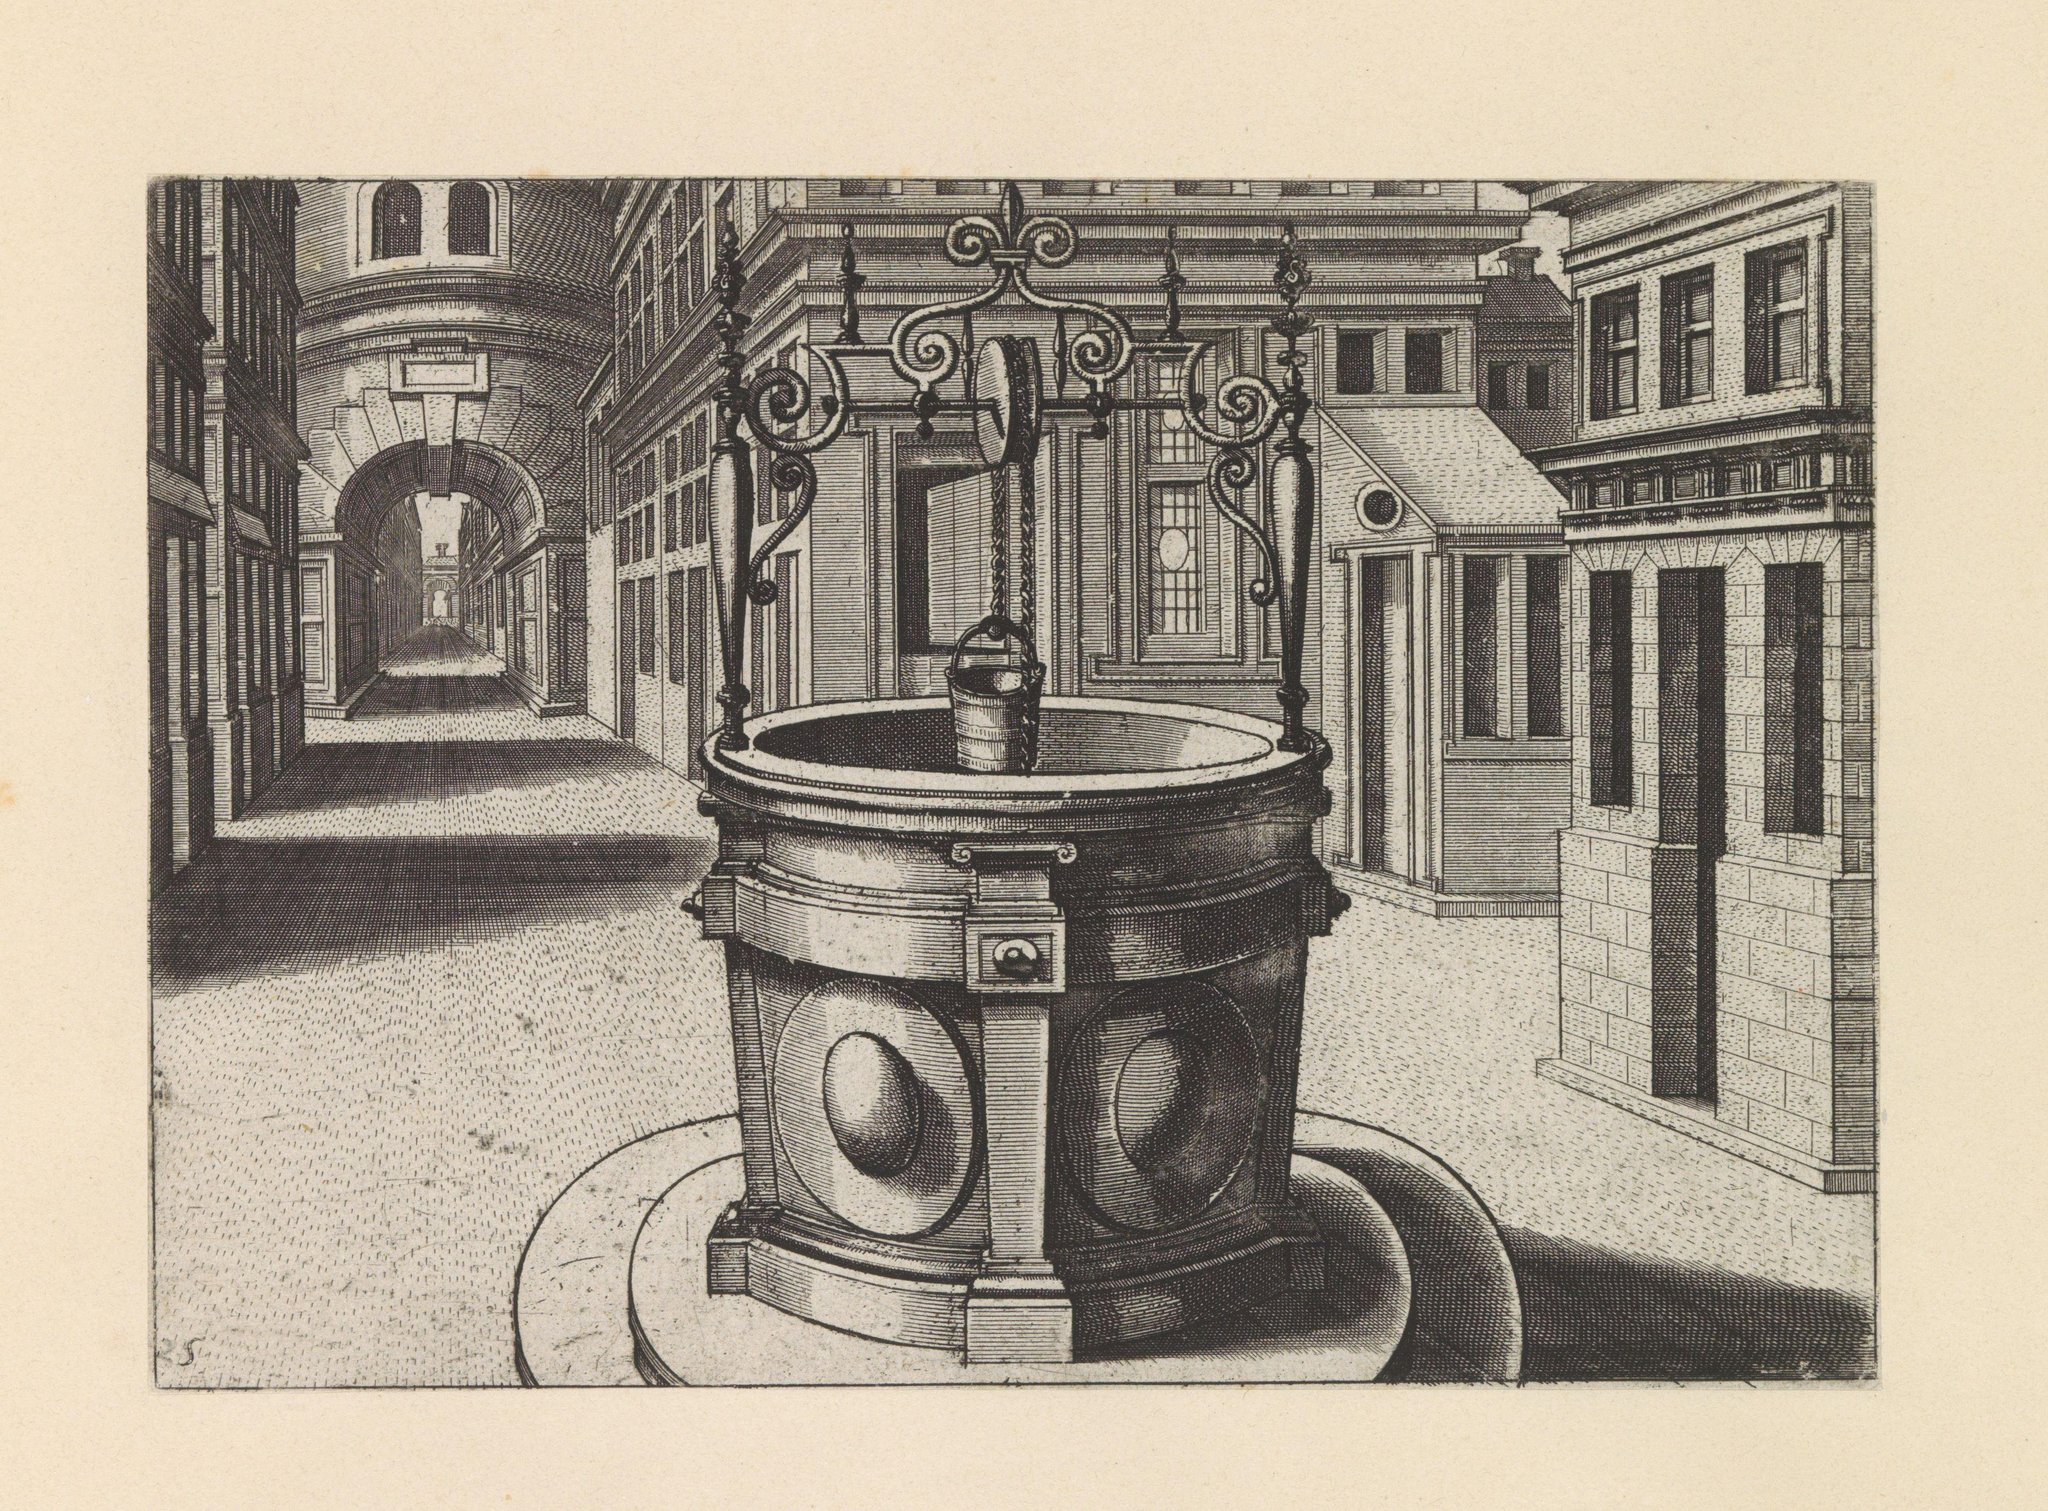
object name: album leaf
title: Straat en ronde waterput met metalen overkapping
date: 1574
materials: paper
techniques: etching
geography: antwerp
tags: well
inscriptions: inscription: ‘2’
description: Een straat met een ronde put. Op de rand van de put staan twee balusters waartussen een metalen constructie bevestigd is. Hieraan hangt de aker over een katrol. De prent maakt deel uit van een album.